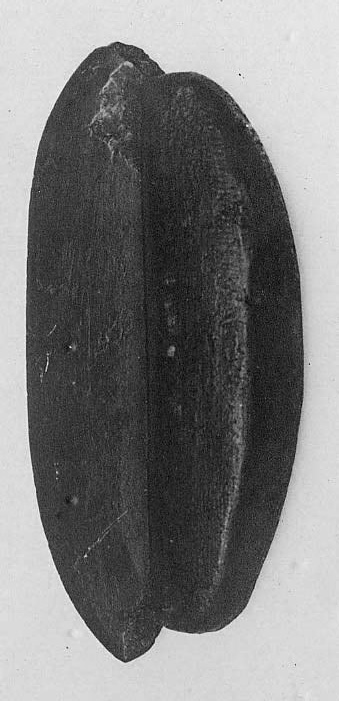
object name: knife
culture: north american, alaskan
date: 1902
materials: jade